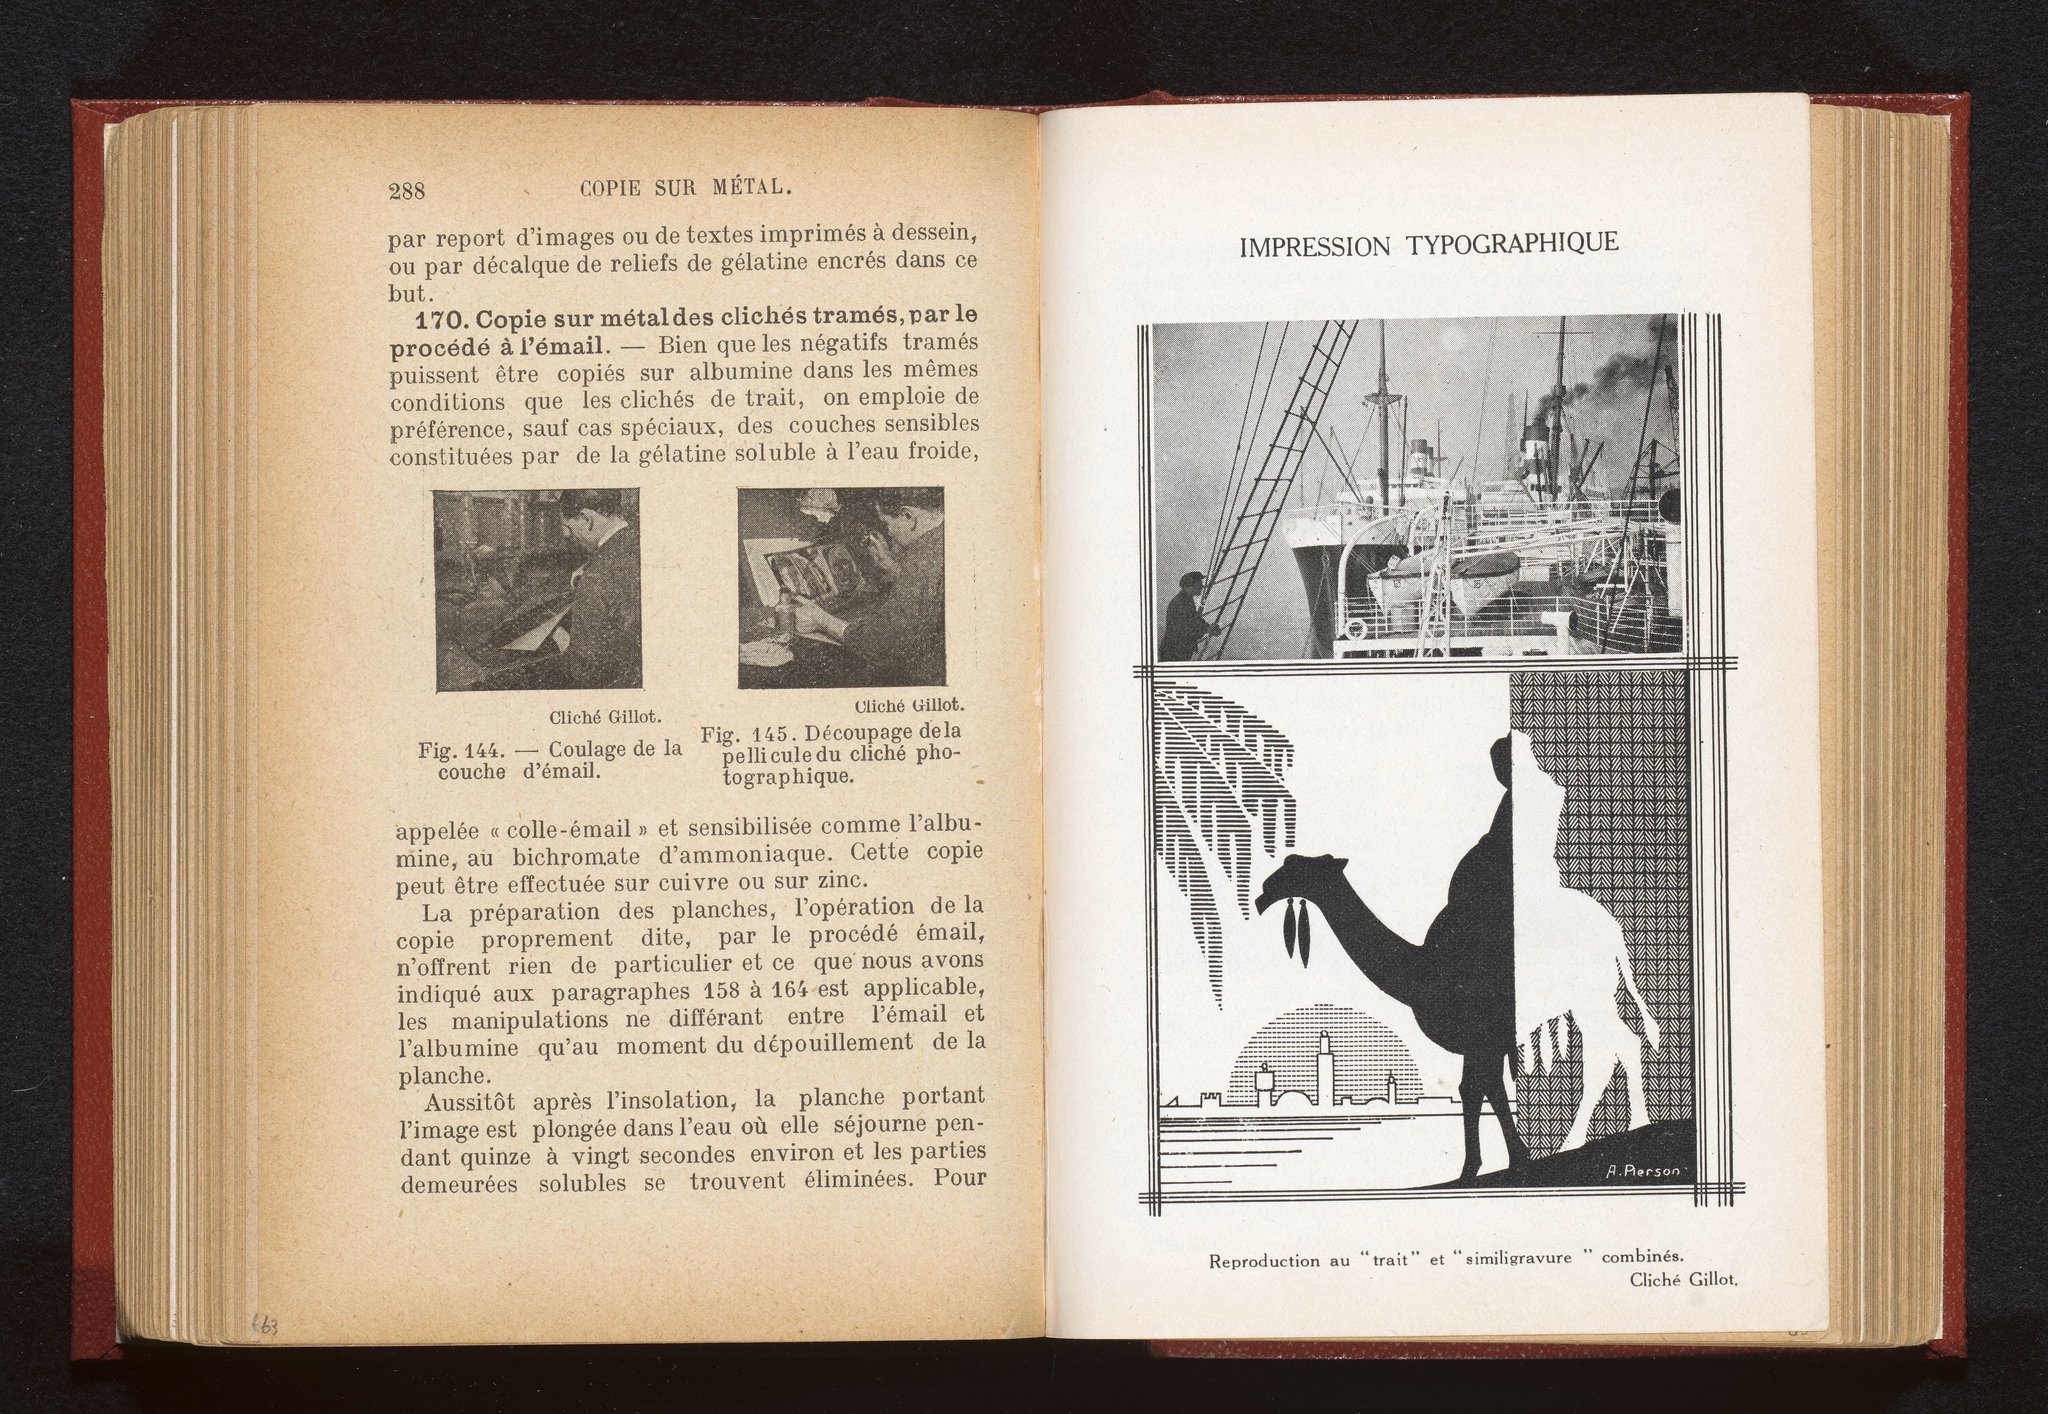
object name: page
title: Coulage de la couche d'email. Découpage de la pellicule du cliché photographique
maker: Anonymous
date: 1922-1932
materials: paper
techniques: autotype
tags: photographic apparatus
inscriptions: number: ‘Fig. 144. Fig. 145.’